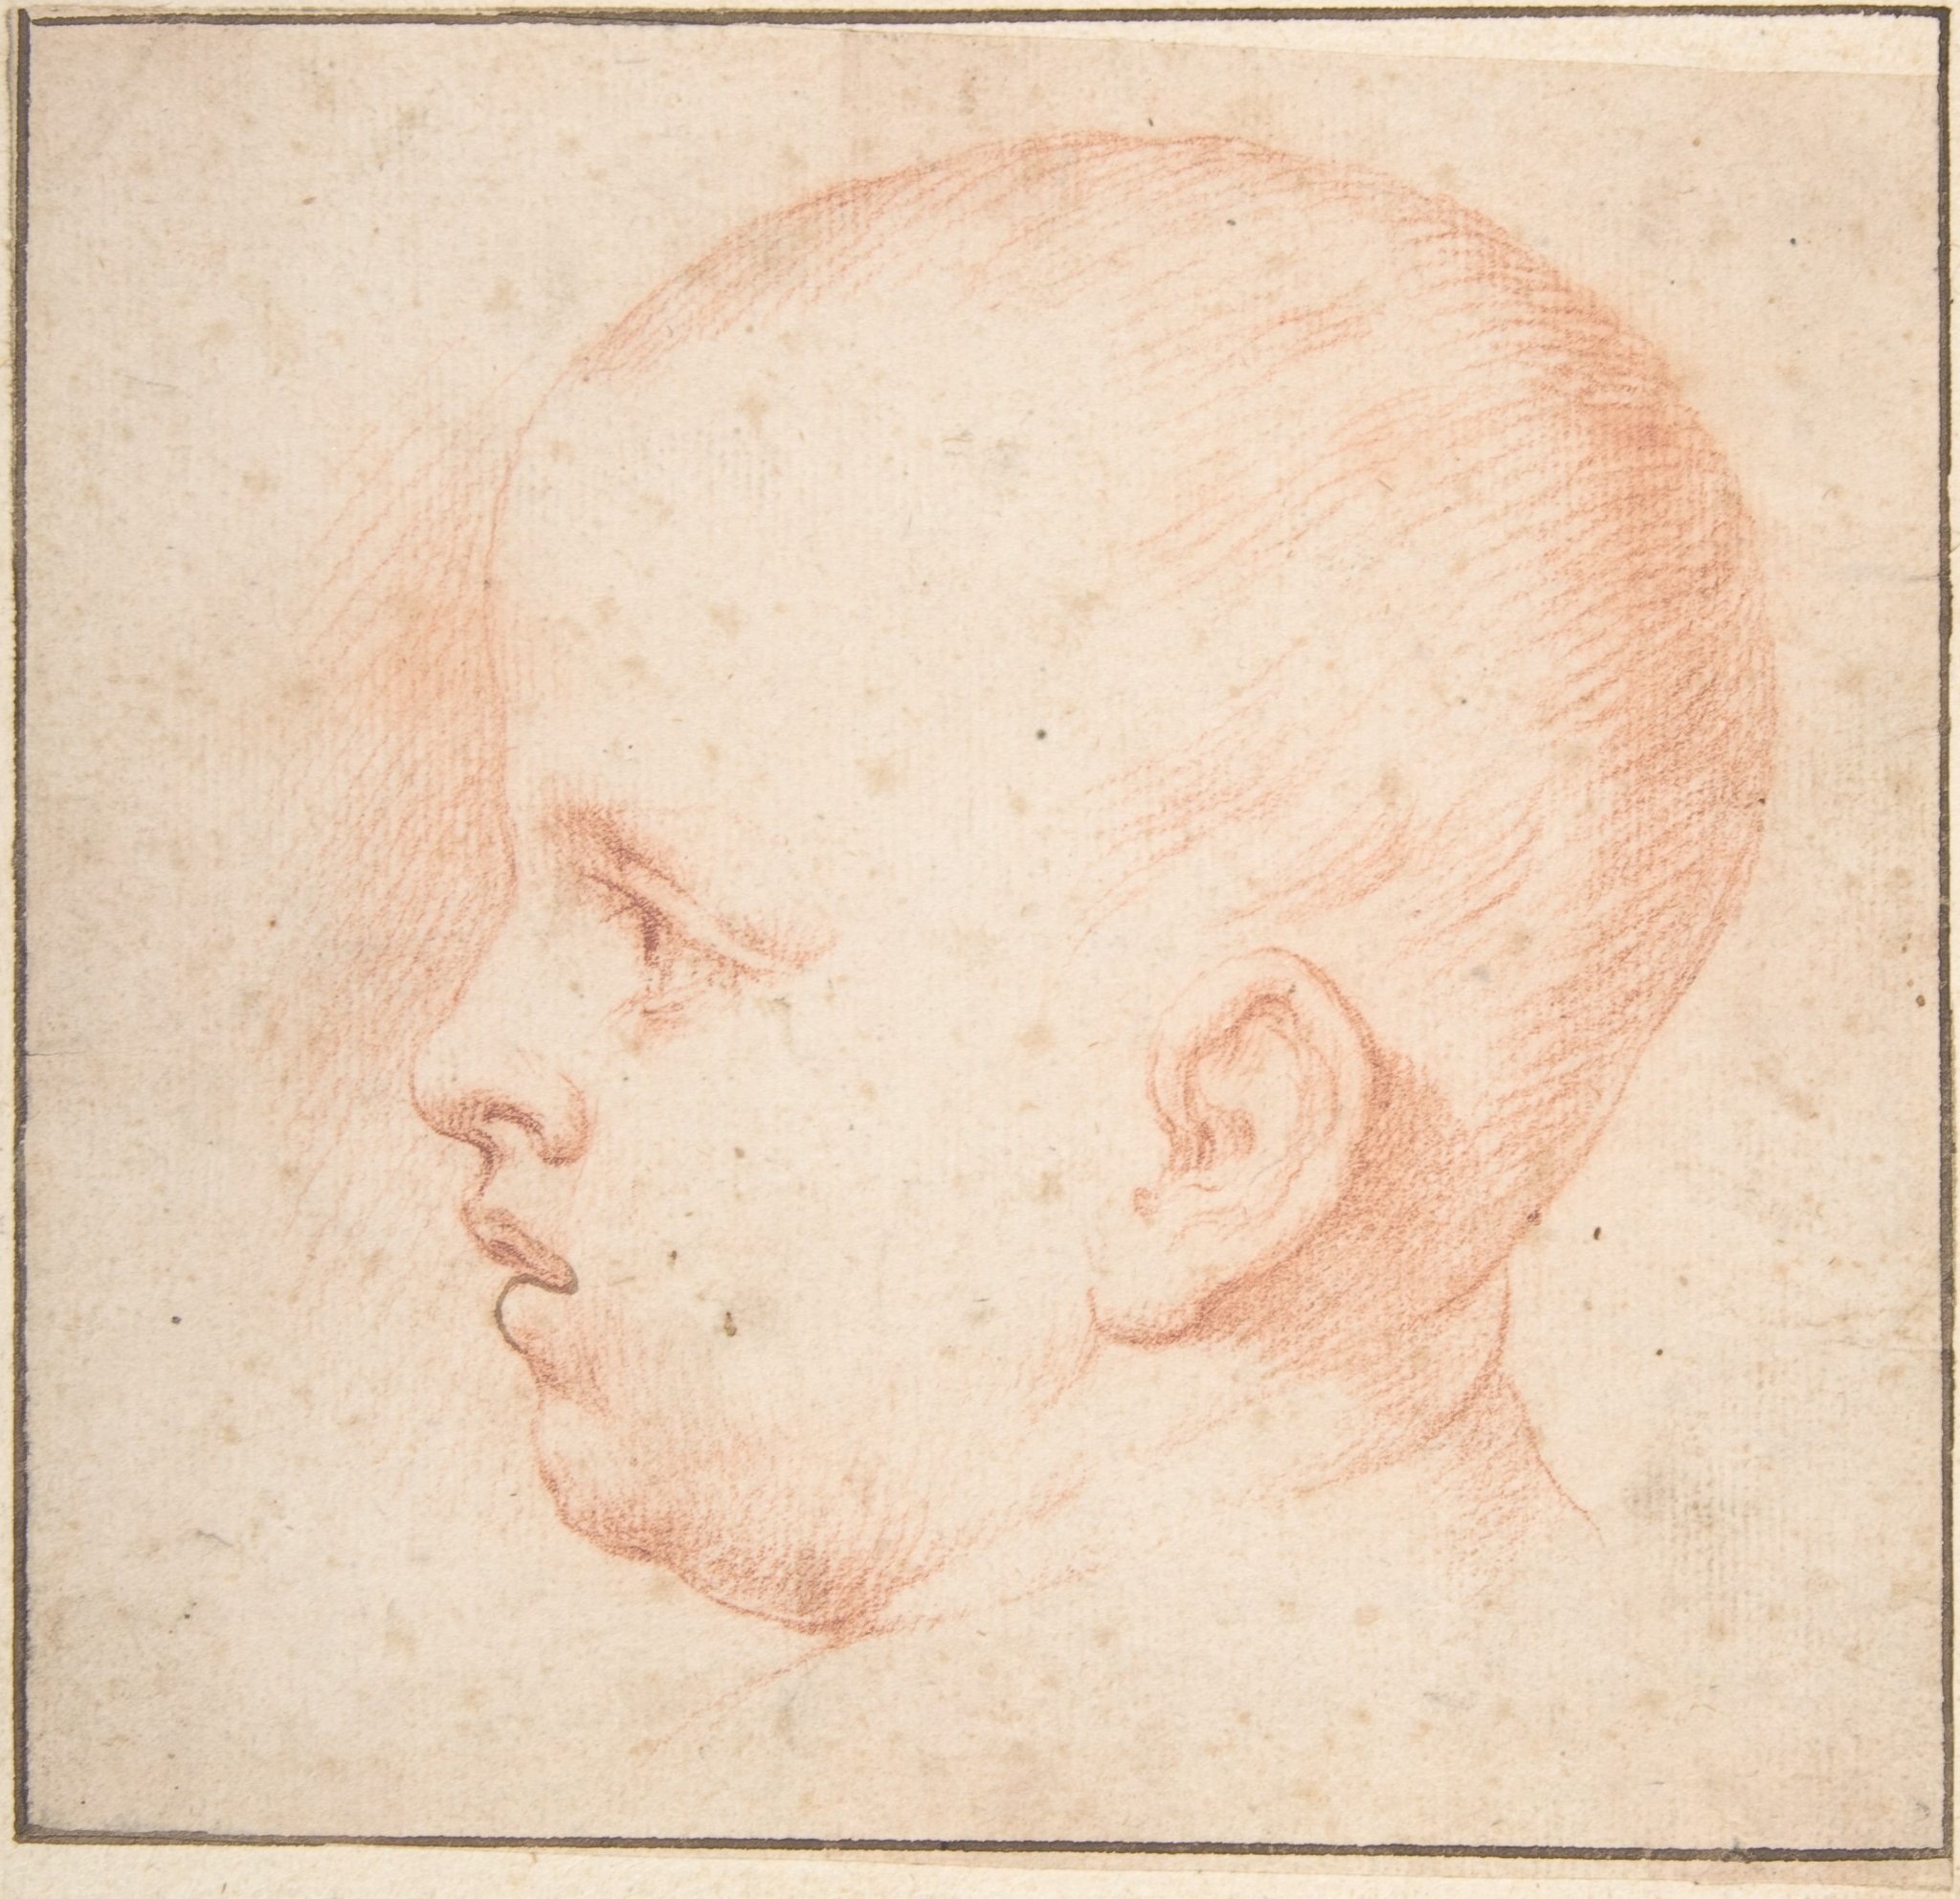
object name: drawing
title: Child's Head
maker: anonymous, french, 18th century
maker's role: artist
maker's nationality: french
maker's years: 1700-1800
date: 1701-1800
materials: chalk, ink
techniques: pen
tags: heads,children,profiles